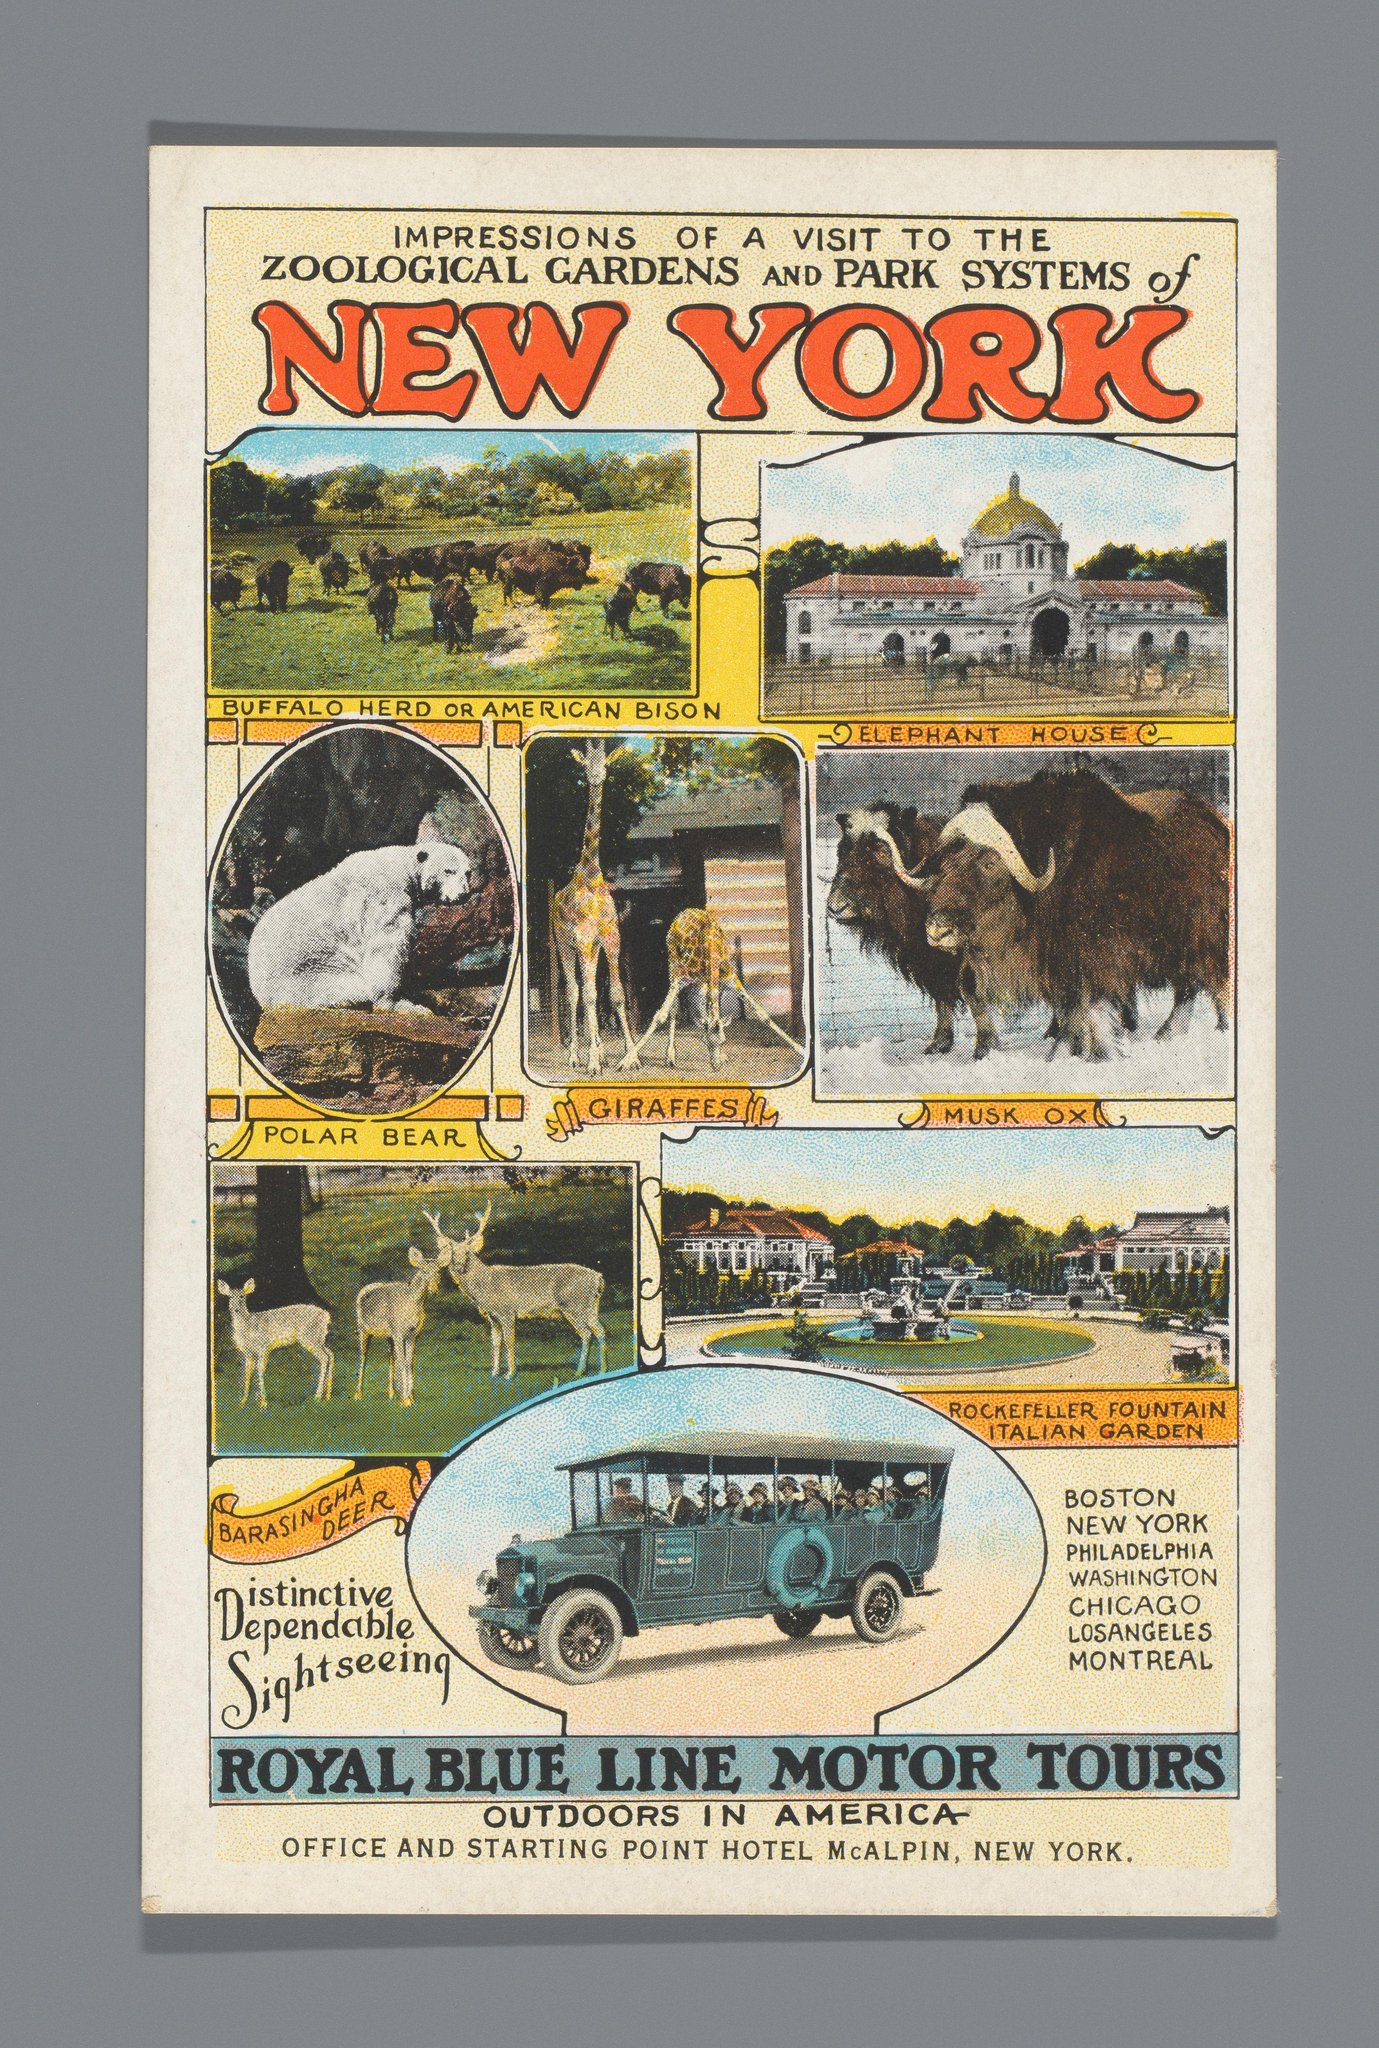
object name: ansichtkaart, prentbriefkaart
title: Reclame voor Royal Blue Line Motor Tours met afbeeldingen uit een of meer dierentuinen in New York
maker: Anonymous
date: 1912-1930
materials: photographic support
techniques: lithograph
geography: united states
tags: united states of america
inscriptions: inscription: ‘IMPRESSIONS OF A VISIT TO THE / ZOOLOGICAL GARDENS AND PARK SYSTEMS OF / NEW YORK […] ROYAL BLUE LINE MOTOR TOURS / OUTDOORS IN AMERICA / OFFICE AND STARTING POINT HOTEL McALPIN, NEW YORK.’